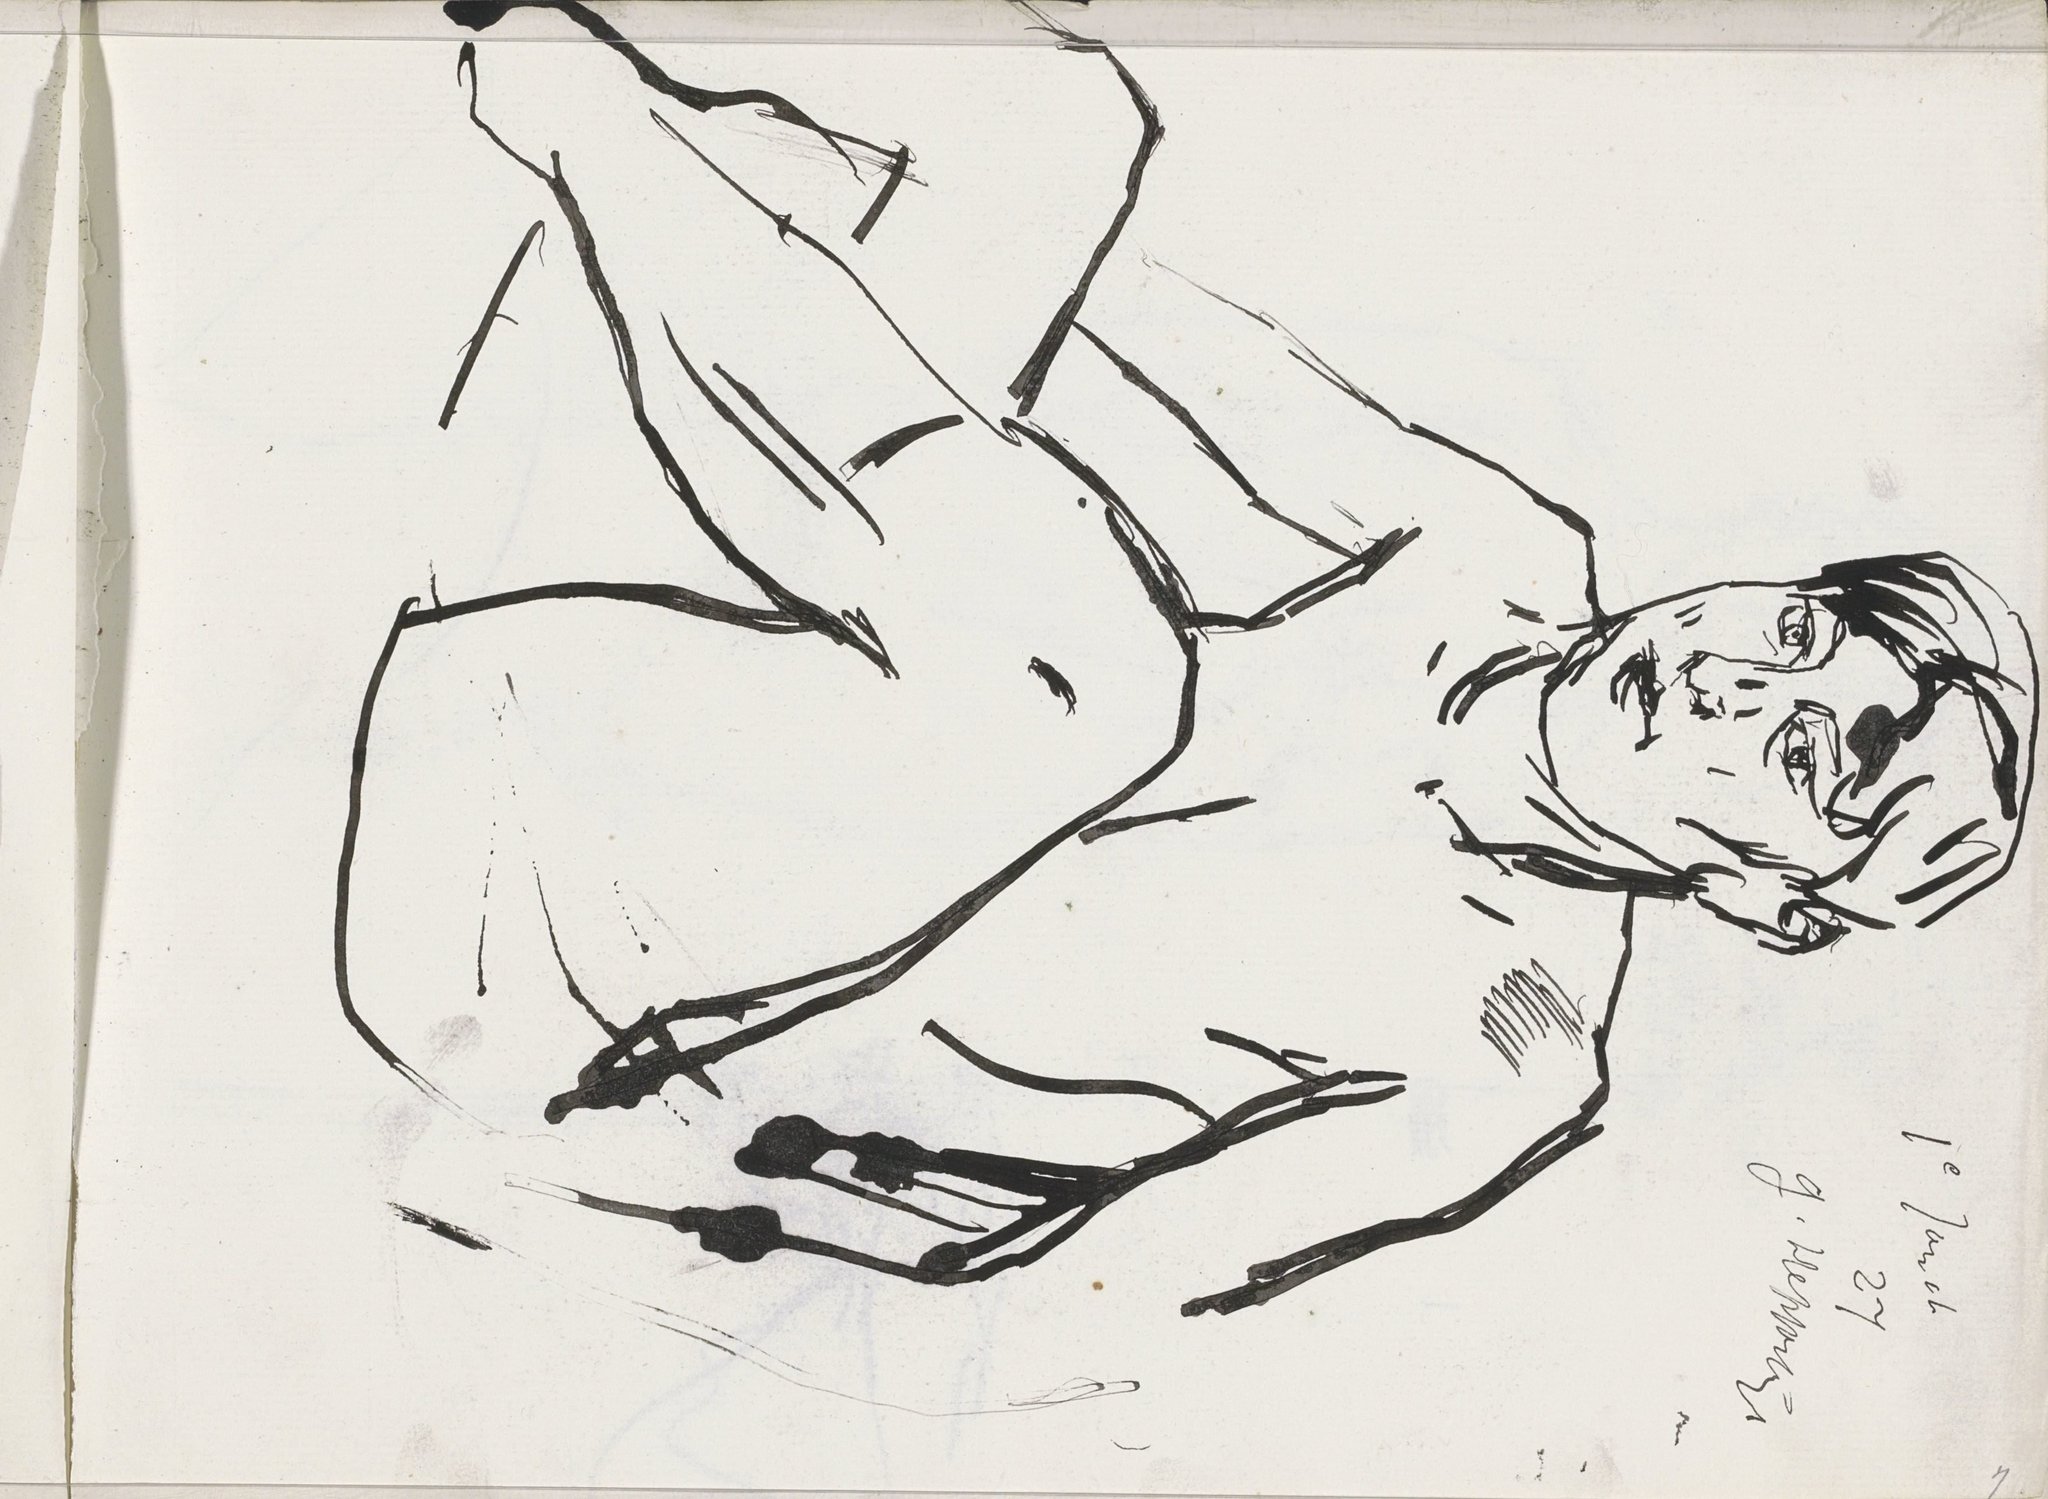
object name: sketchbook leaf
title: Seated Female Nude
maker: isaac israels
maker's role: draughtsman, painter, print maker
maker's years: 1865-1934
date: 1875-1934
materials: ink, paper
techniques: brush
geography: the hague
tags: the (nude) human figure; 'corpo humano' (ripa) - aa - female human figure (+ sitting)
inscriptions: annotation: ‘1e Jan str / 27 / G. Heppings[?]’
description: Met opgetrokken benen. Blad 7 recto uit schetsboek XXI met 19 bladen.